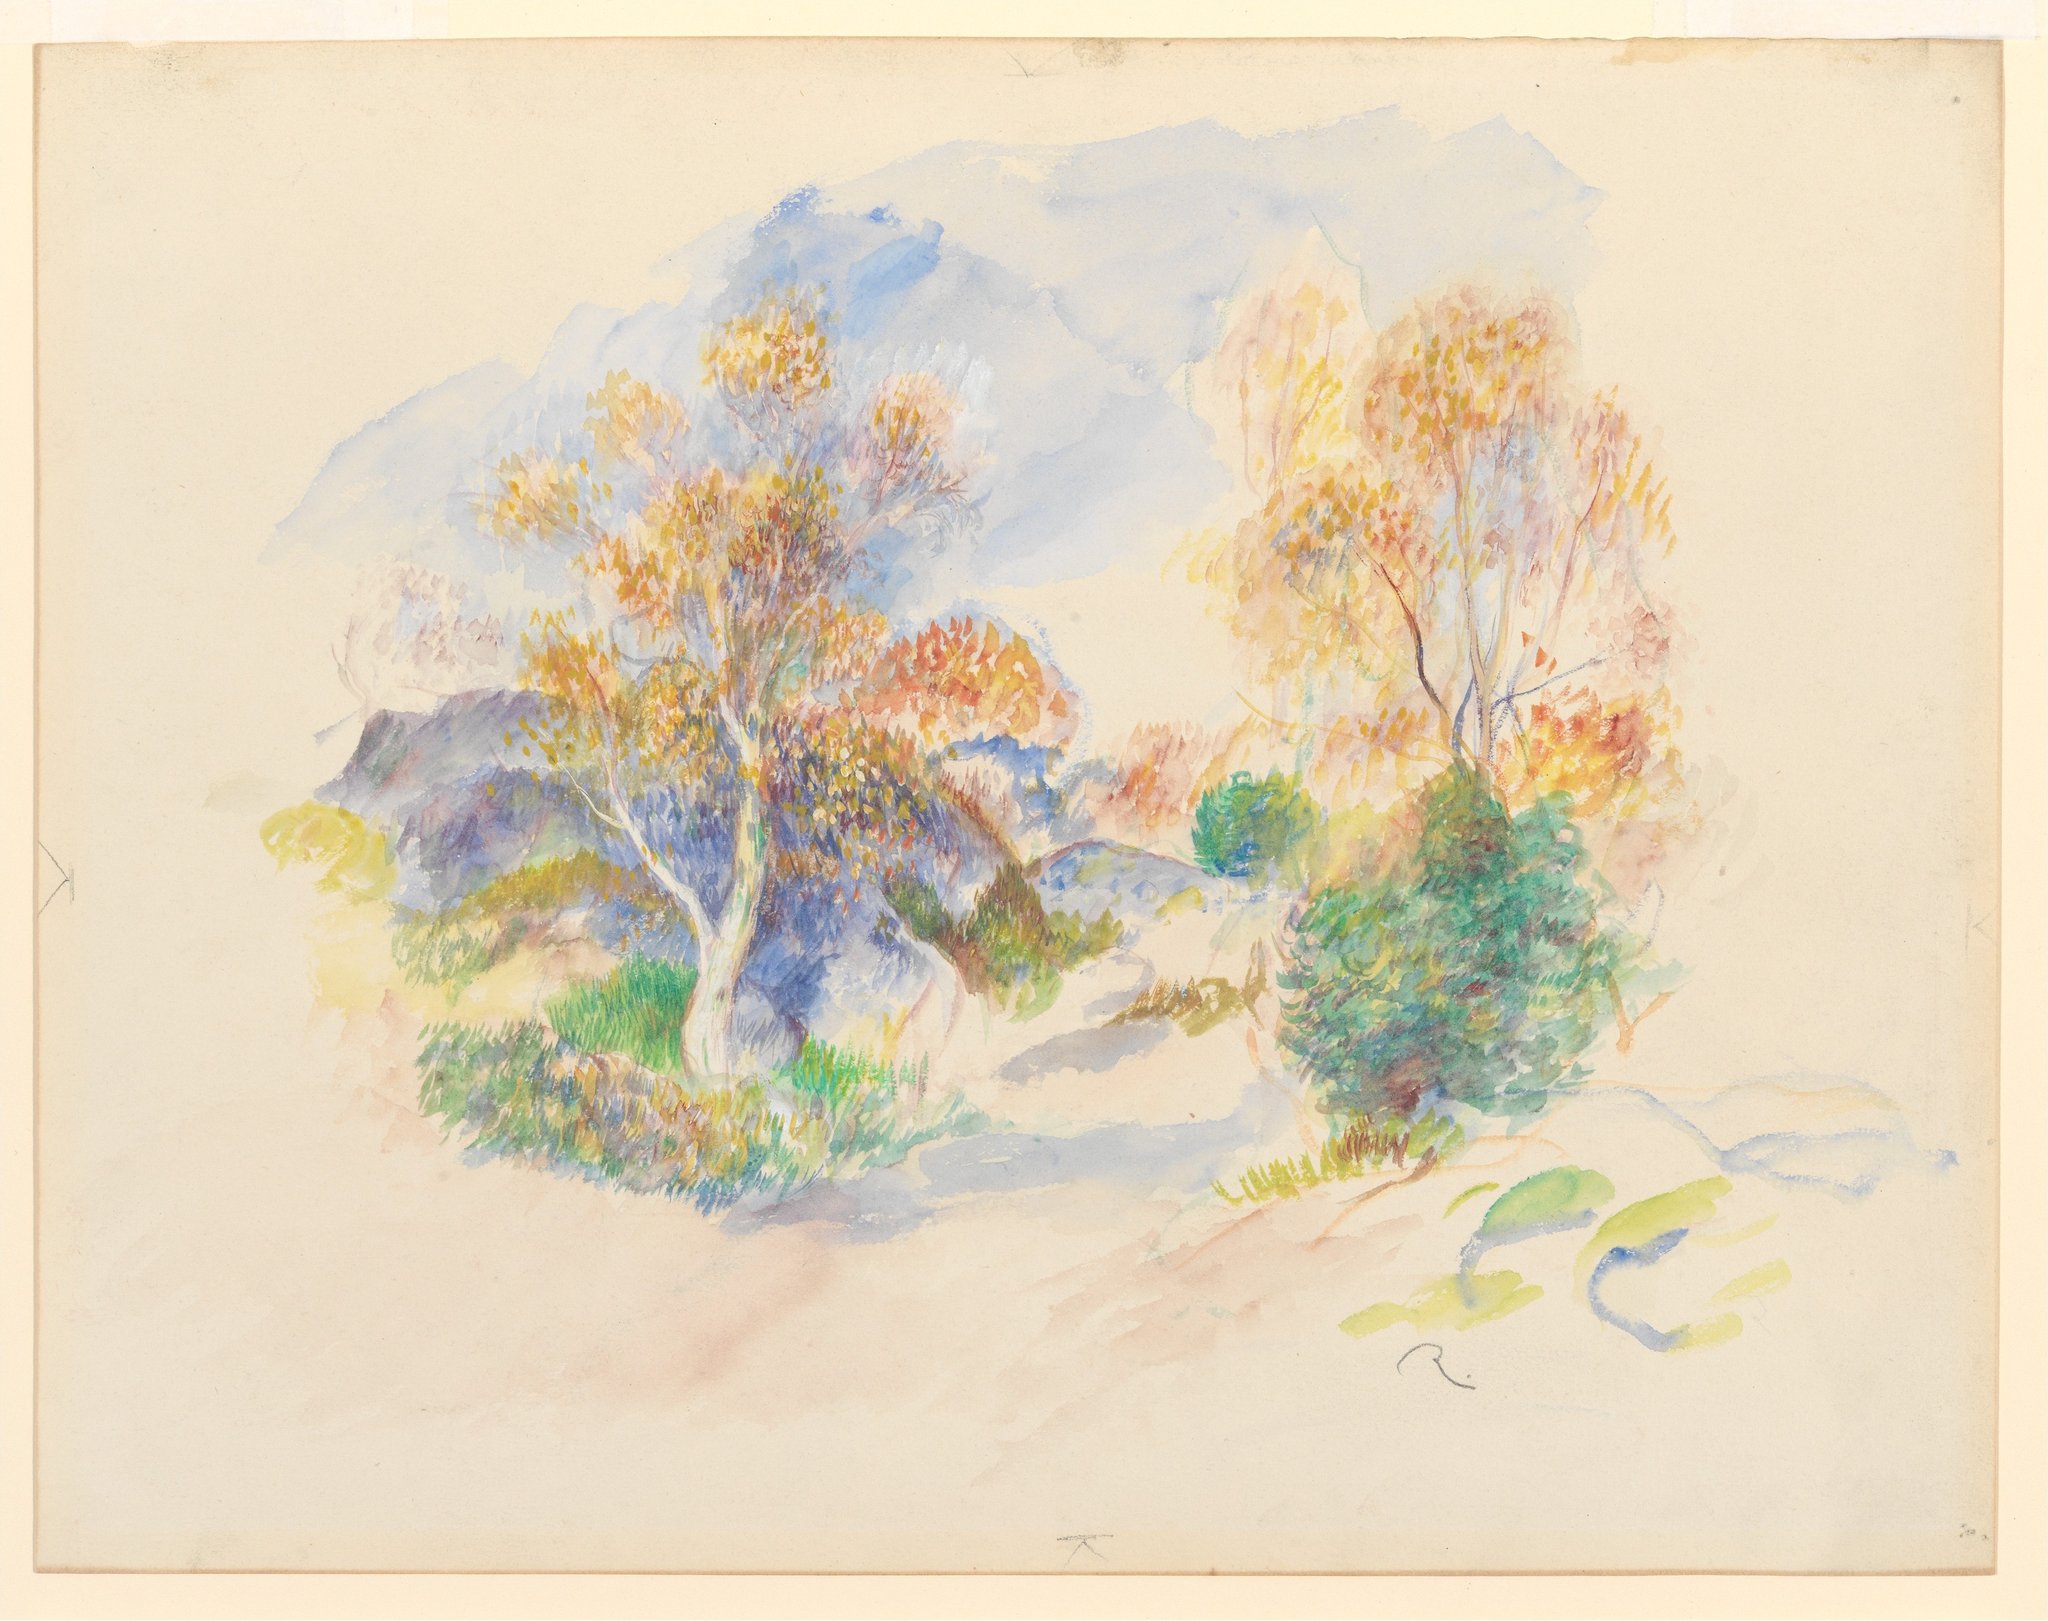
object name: drawing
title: Landscape with a Path between Trees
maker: pierre auguste renoir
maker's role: artist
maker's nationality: french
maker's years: 1841-1919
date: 1886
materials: gouache, watercolor, paper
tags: landscapes,trees